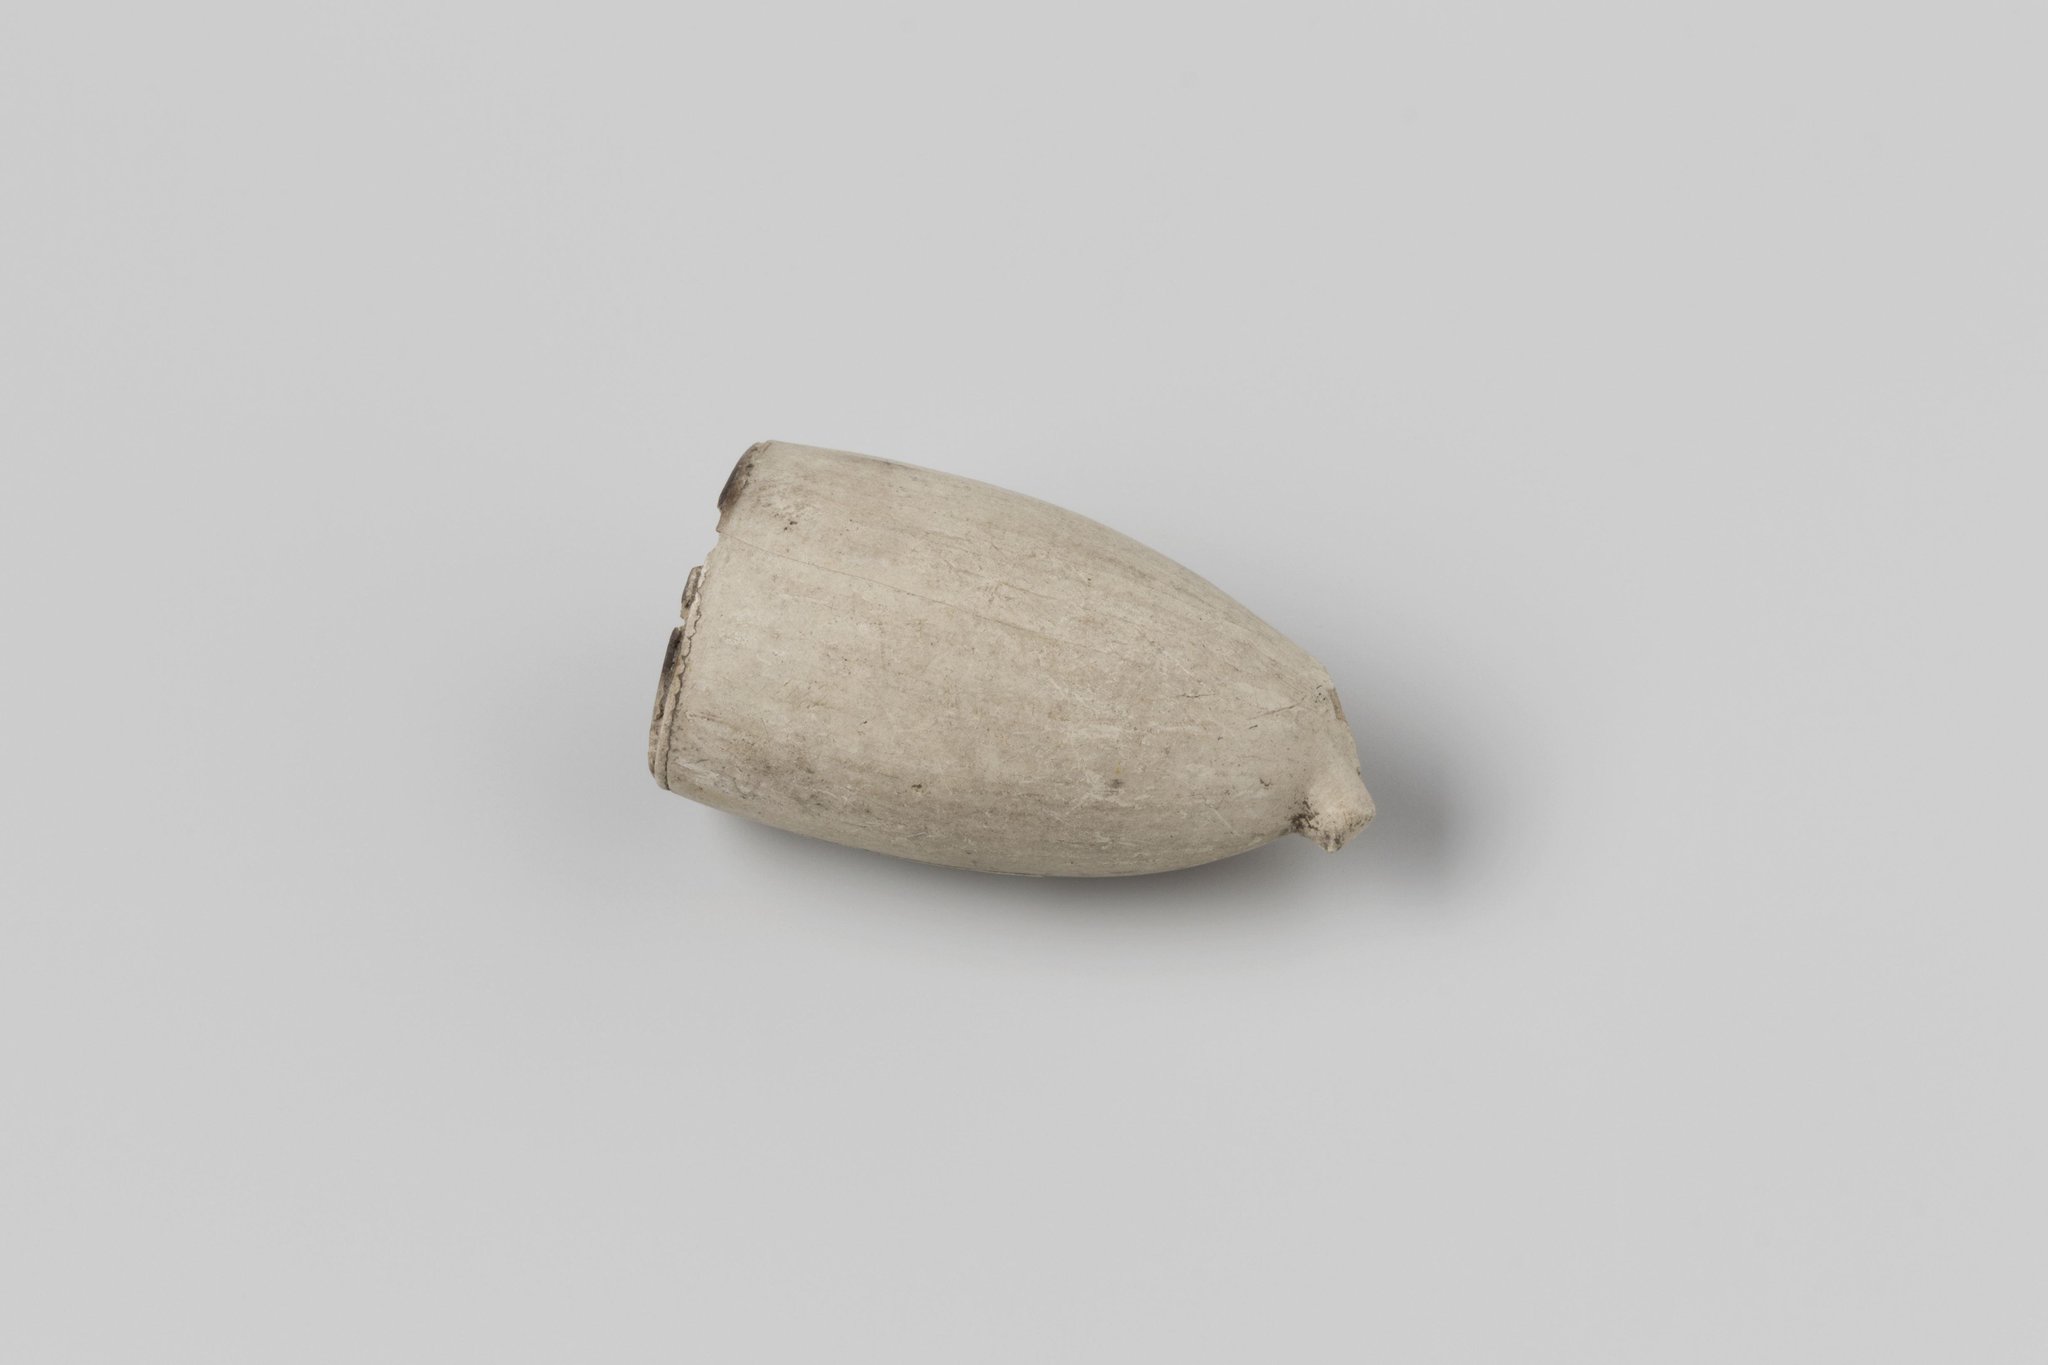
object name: pipe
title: Fragment pijpenkop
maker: Anonymous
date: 1750-1780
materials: clay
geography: alphen aan den rijn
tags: directeur, hoogleraar, caspar jacob christiaan reuvens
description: Fragment pijpenkop. Van de opgravingen op de Hofstede Arentsburg 1827-1831 onder toezicht van Professor Reuvens.